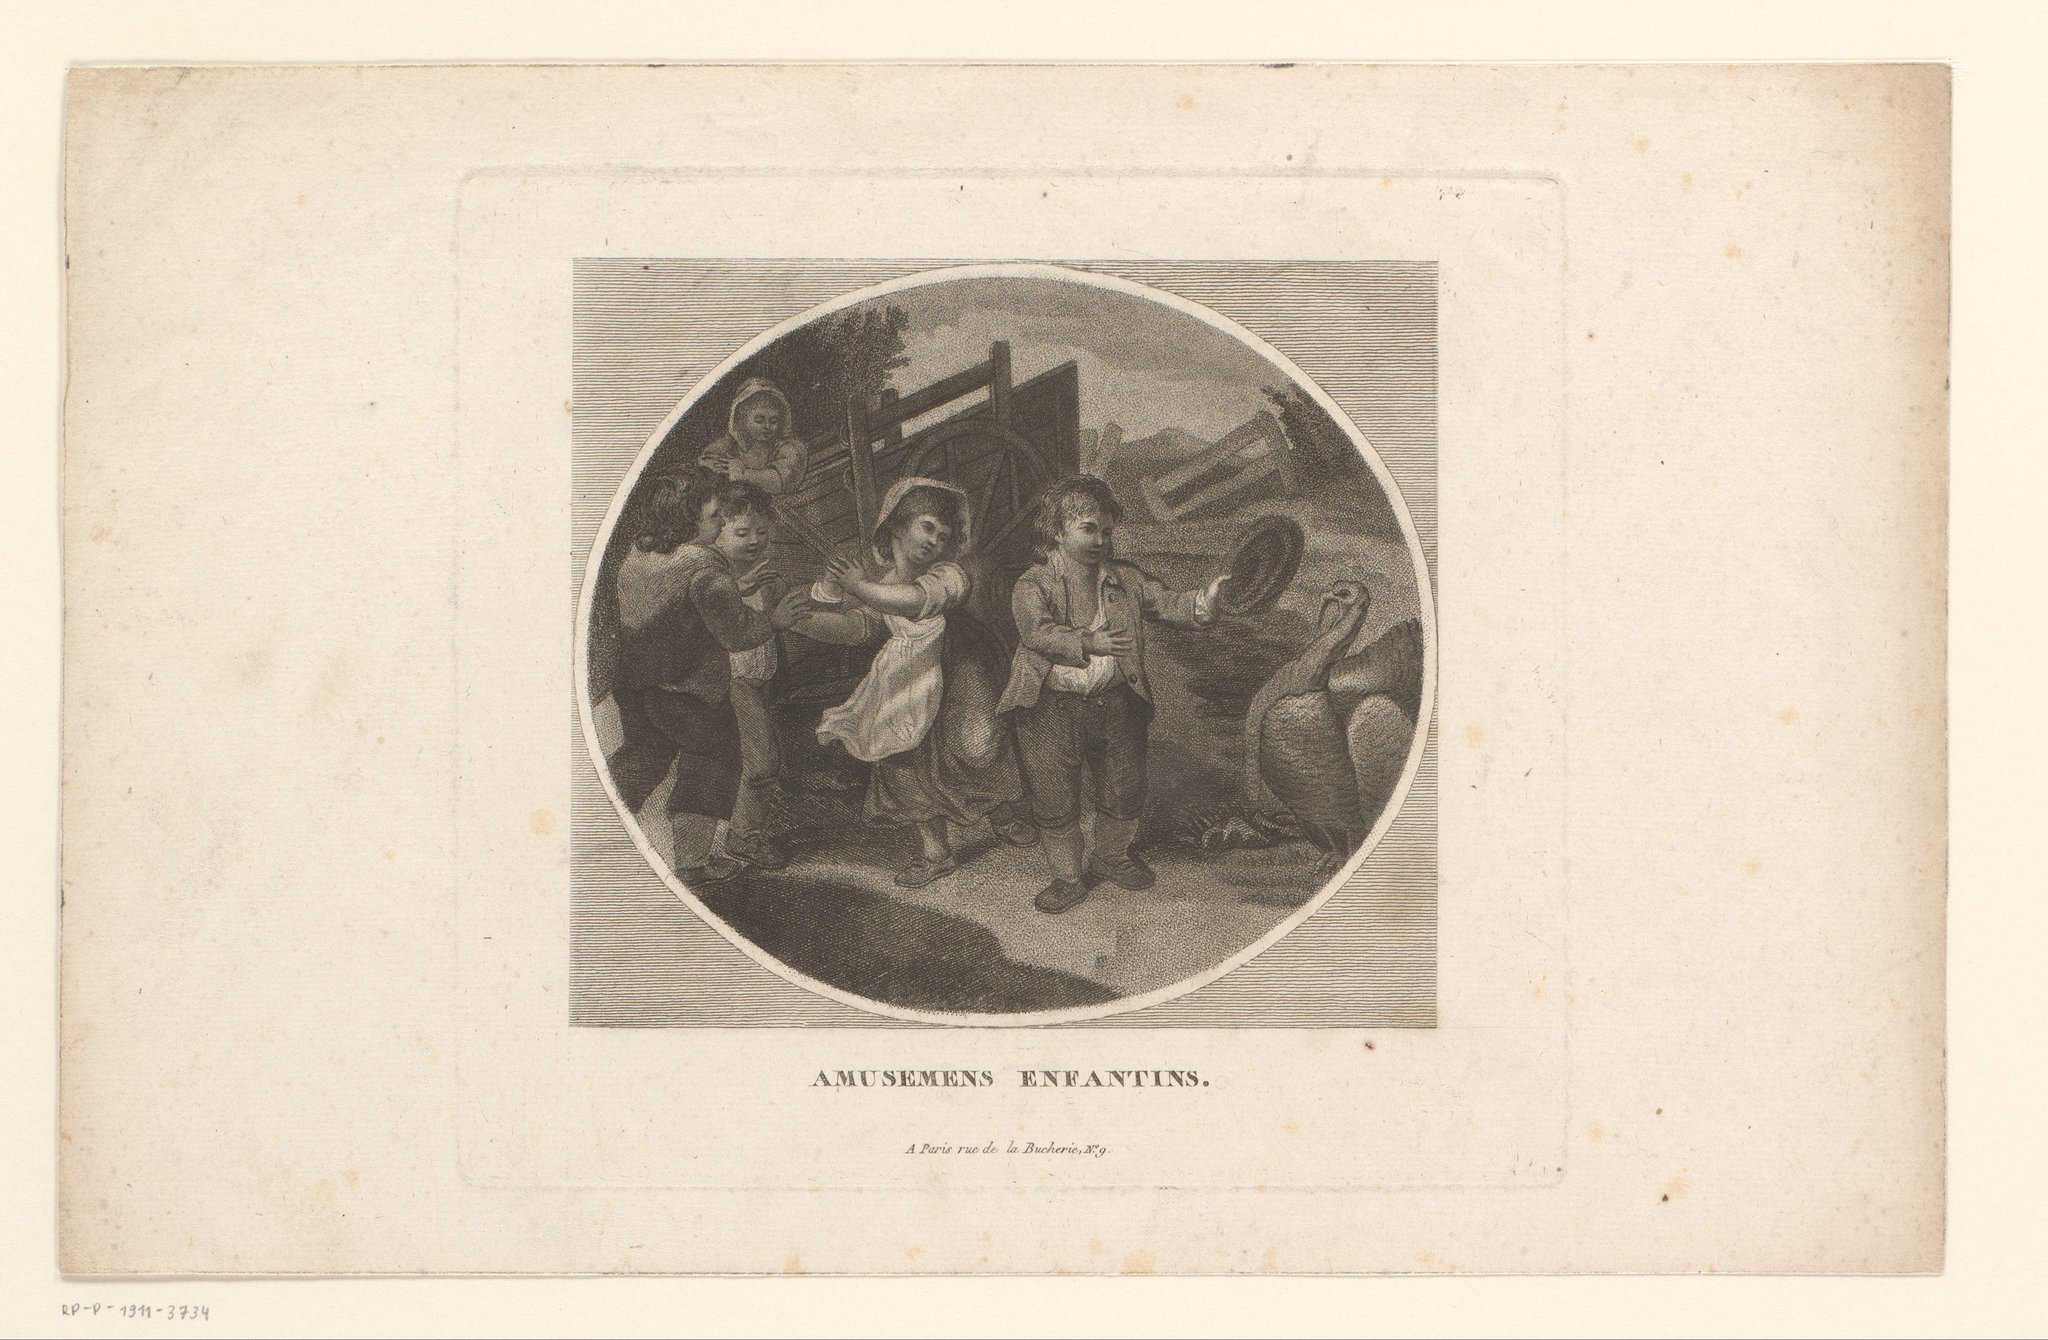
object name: print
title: Amusemens enfantins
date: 1800-1850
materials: paper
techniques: engraving, etching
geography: france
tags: other children's games, walker and runner birds: turkey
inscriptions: collector's mark: Lugt 2228